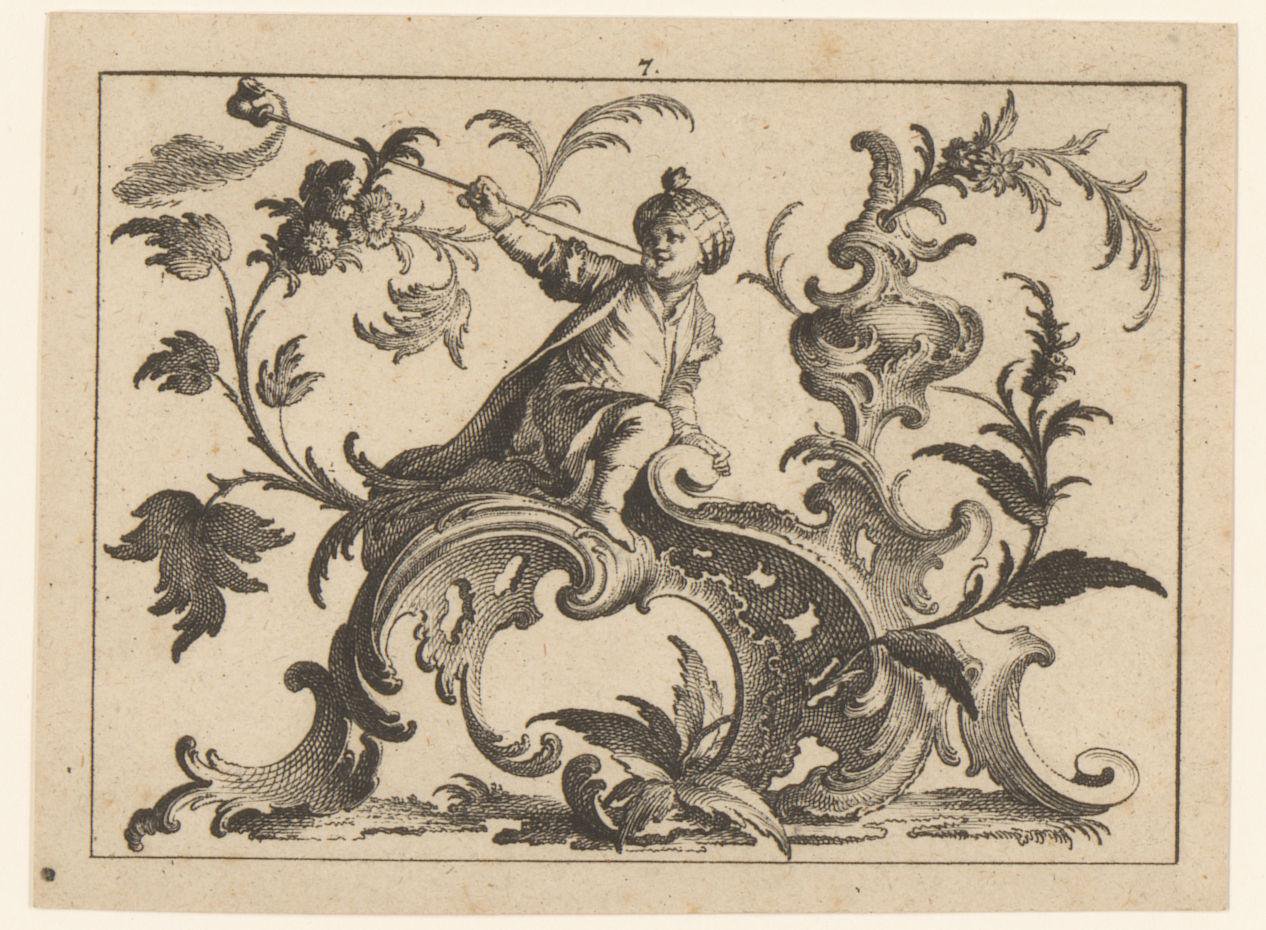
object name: ornament print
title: Pijprokende man met tulband gezeten op een rococo-ornament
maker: johann esaias nilson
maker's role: draughtsman, print maker, publisher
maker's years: 1721-1788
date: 1731-1788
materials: paper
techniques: engraving, etching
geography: augsburg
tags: pipe ~ tobacco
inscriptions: collector's mark: Lugt 2228, collector's mark: Lugt 2760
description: Na de overname van de firma Niemeyer door British American Tabacco Group besloot deze de collectie van het Niemeyer Tabaksmuseum af te stoten. De beheerder van de collectie, het Noordelijk Scheepvaartmuseum, organiseerde in januari 2011 open dagen voor musea waar deze hun voorkeuren voor collectieonderdelen kenbaar konden maken. De objecten zijn getaxeerd door medewerkers van Christie's en vervolgens ter overname aangeboden aan de belangstellende musea. Het Rijksprentenkabinet koos 46 prenten uit de collectie tegen door de medewerkers van Christie's vastgestelde waarde. [H. Leeflang, 2011-06-09]. Nummer 1-4, 3-8 en 9-12 komen van één plaat.